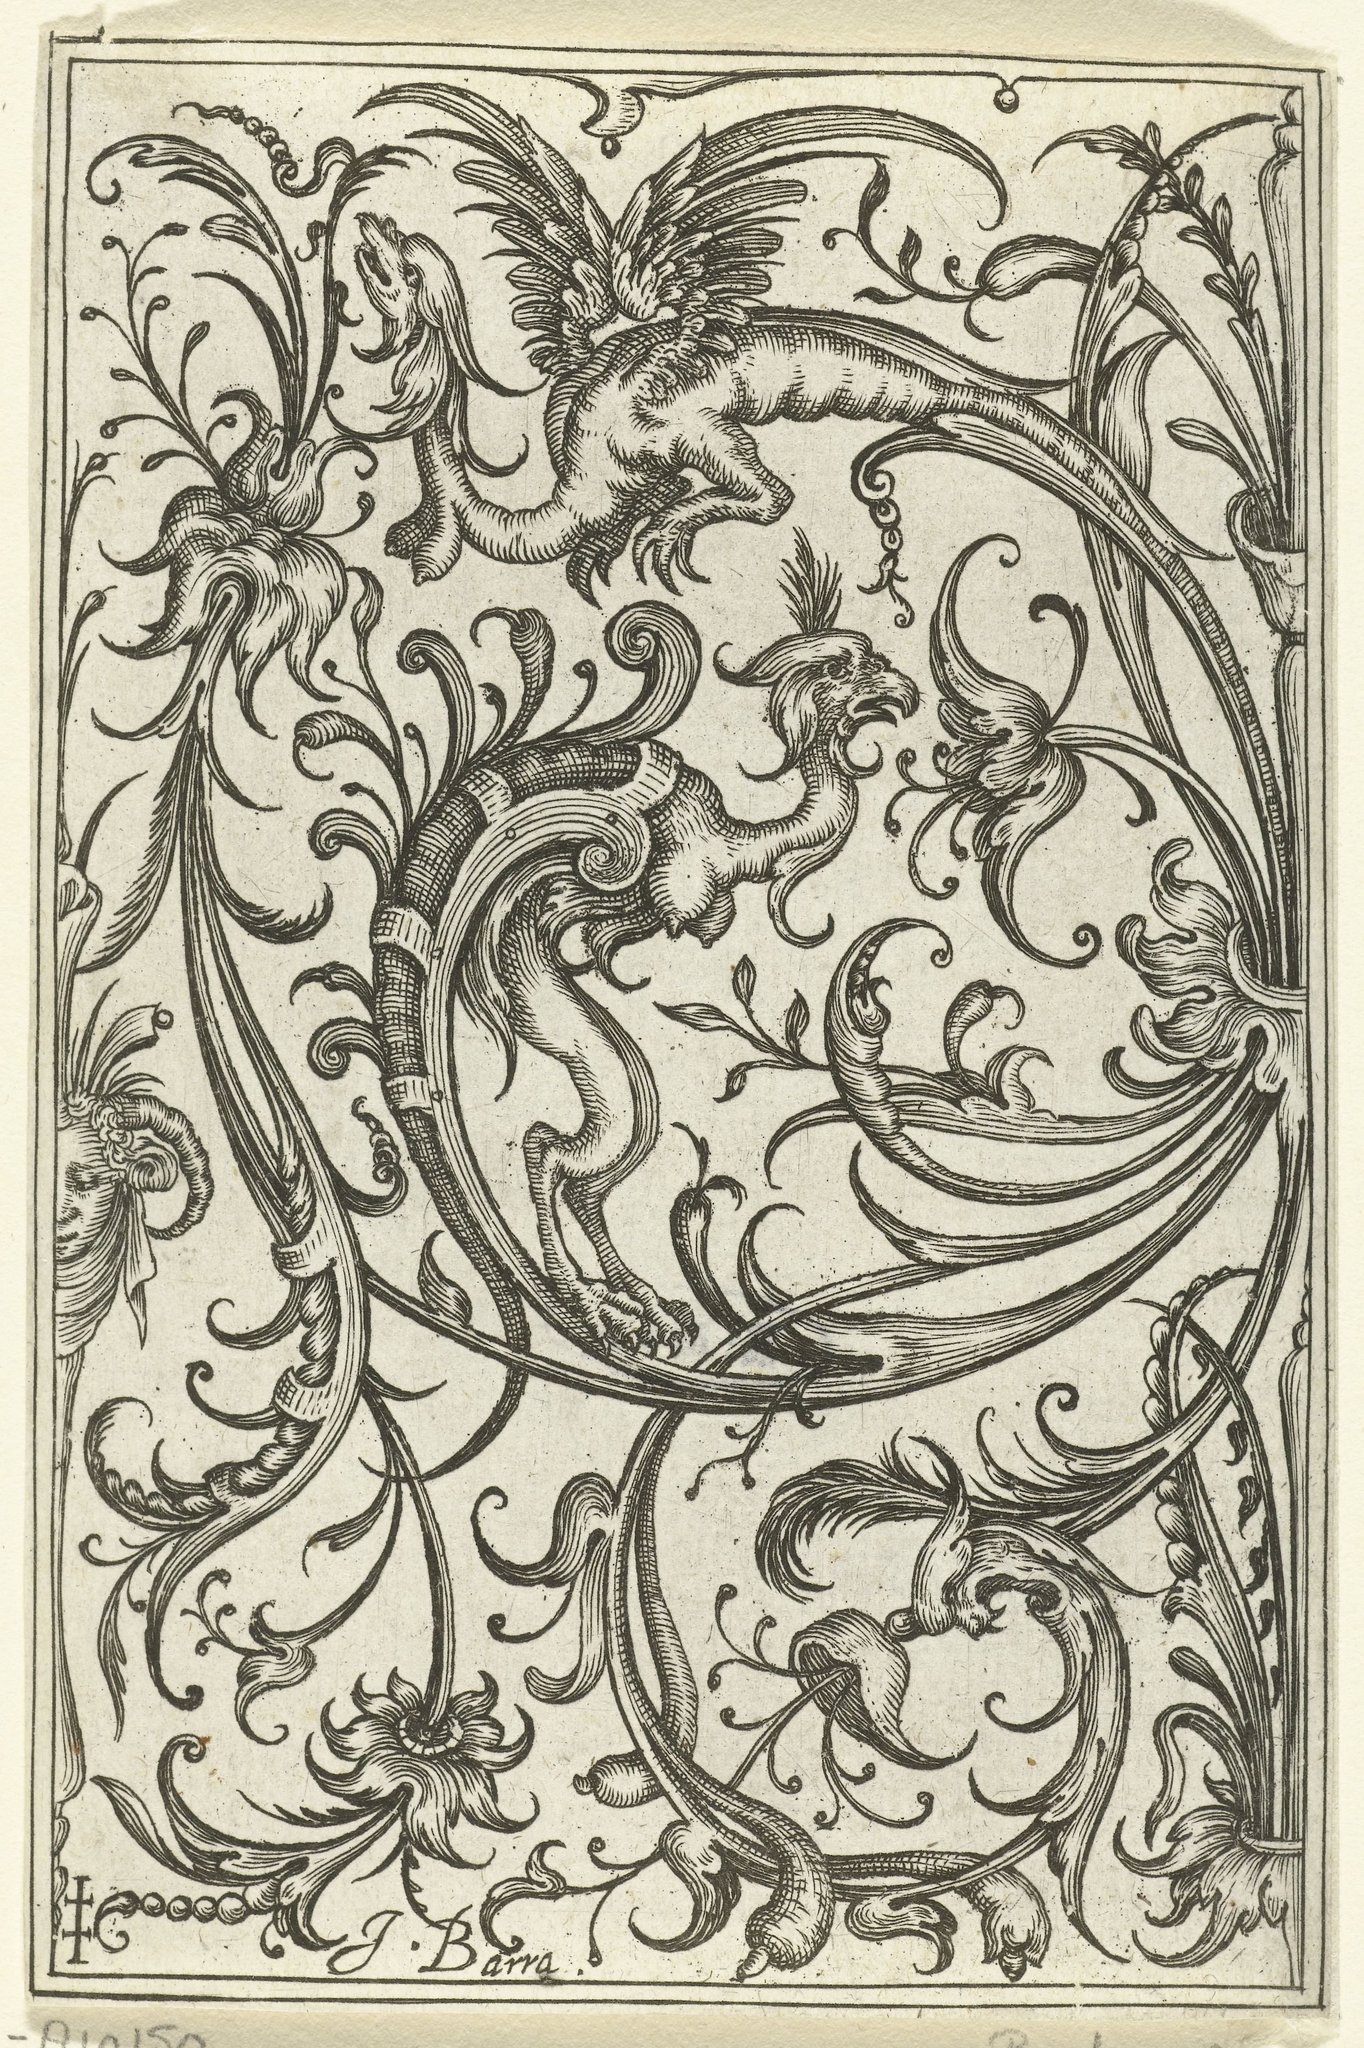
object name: print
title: Paneel met bladranken die uitlopen in twee draken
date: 1623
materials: paper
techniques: engraving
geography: london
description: Uit serie van 12 bladen met bladranken en grotesken, opgedragen aan George Henriot.